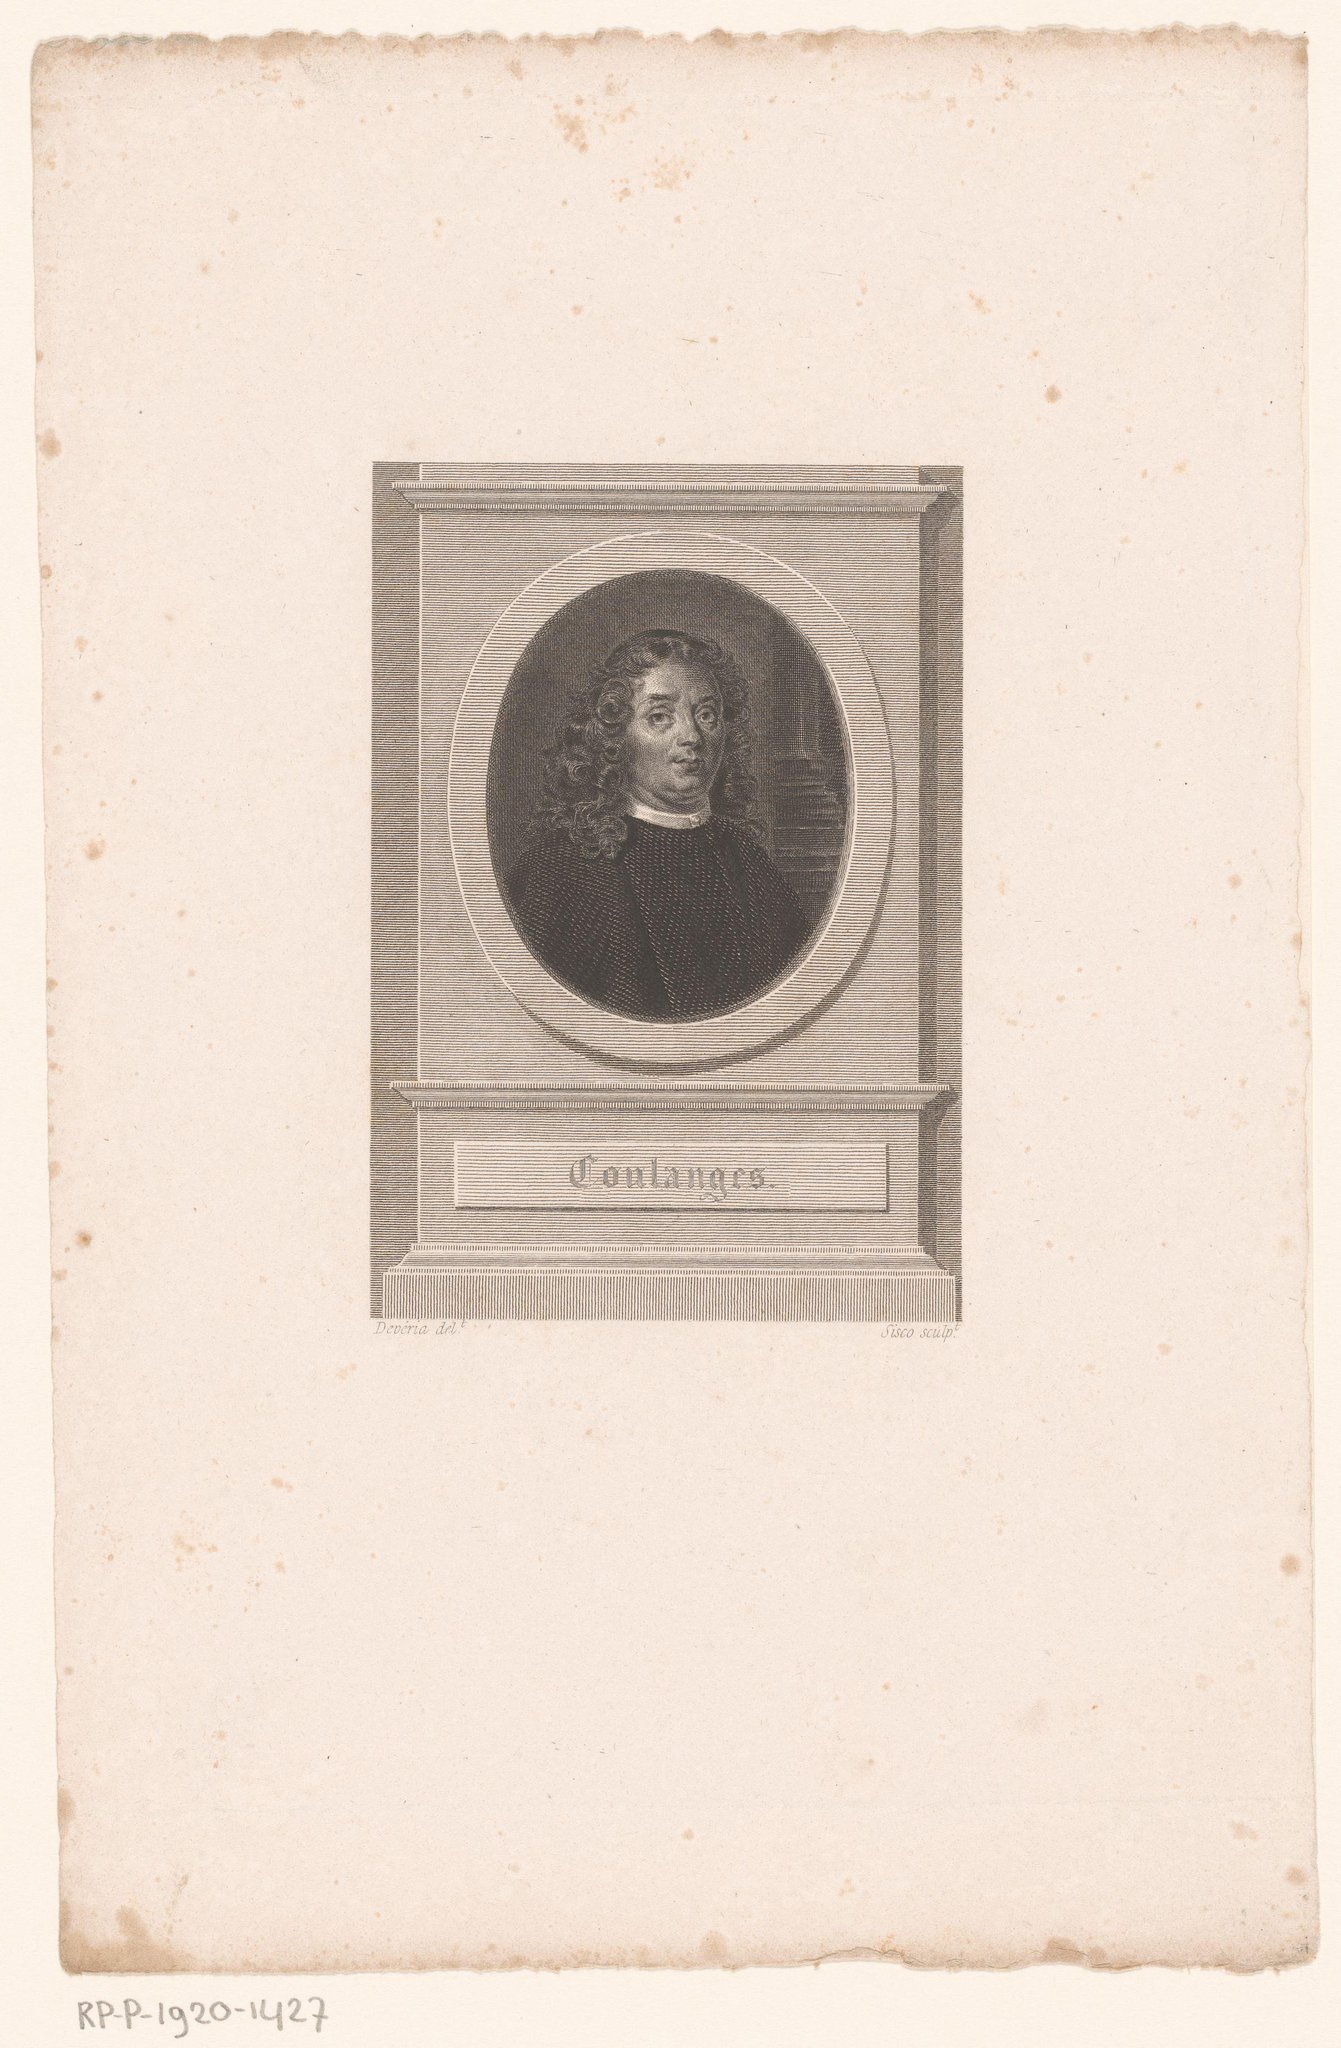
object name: print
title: Portret van Philippe-Emmanuel Coulanges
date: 1788-1861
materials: paper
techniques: engraving, etching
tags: paris, historical persons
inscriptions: collector's mark: Lugt 2228